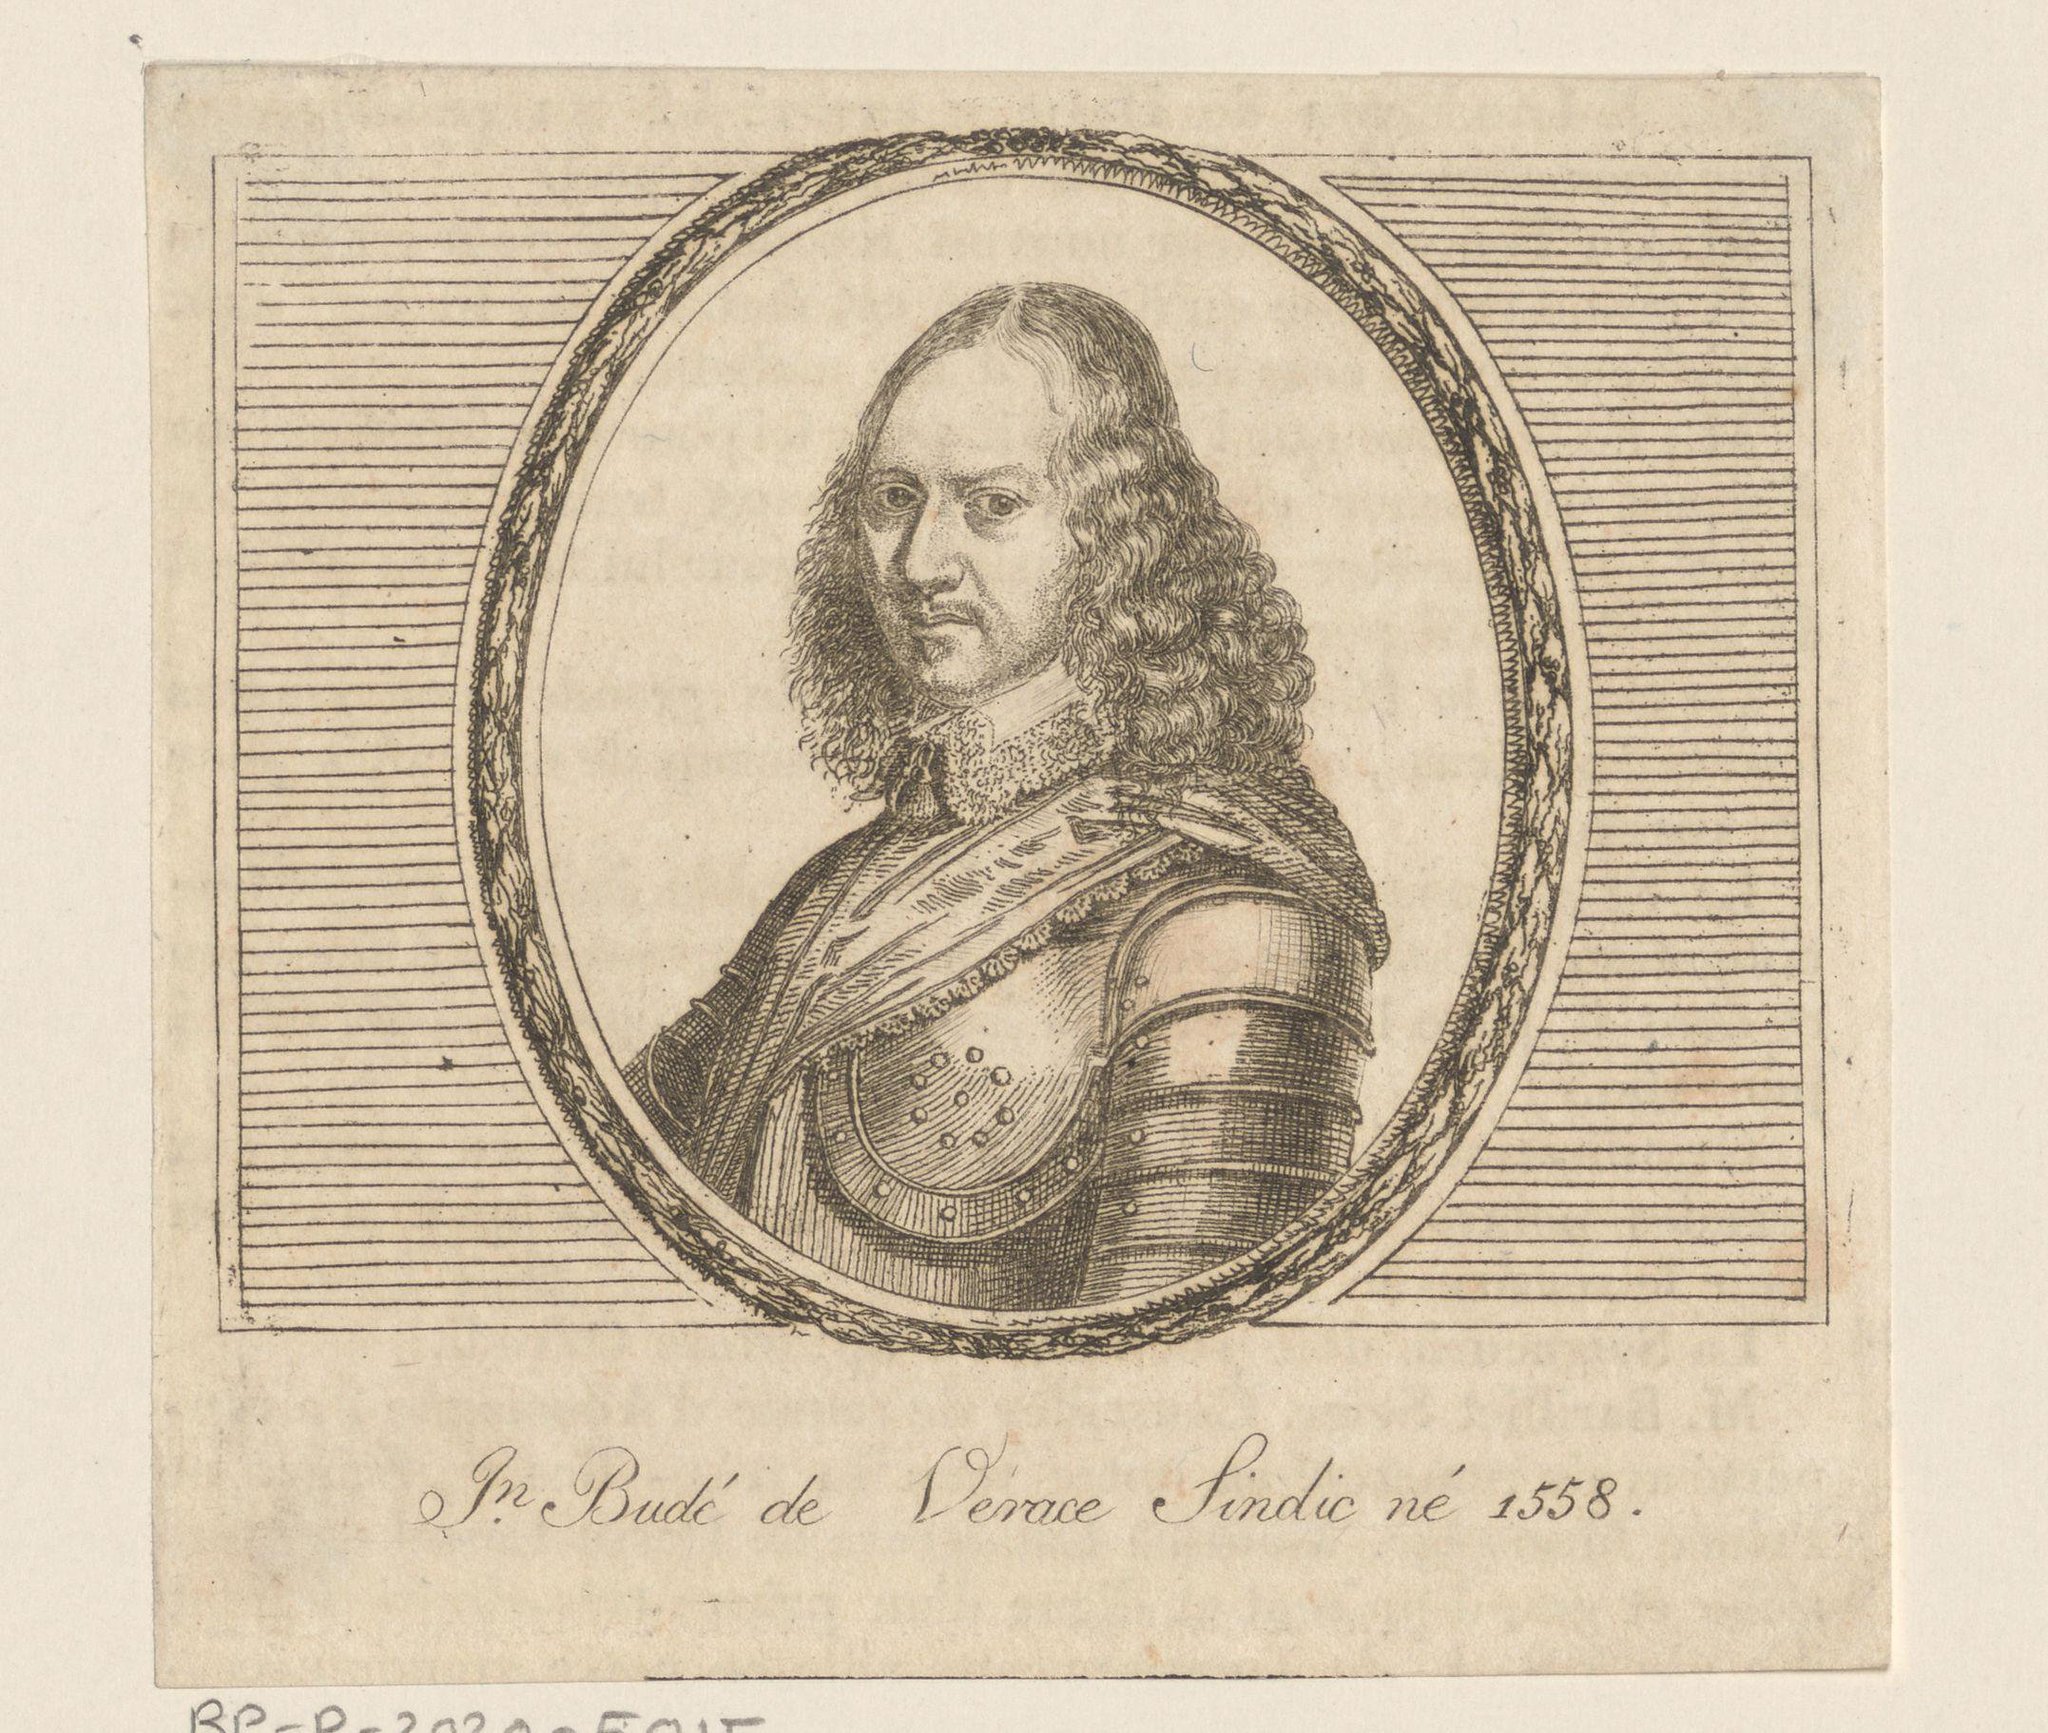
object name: print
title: Portret van Jean Budé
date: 1815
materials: paper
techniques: engraving, etching, letterpress printing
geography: geneva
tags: armour, historical persons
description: Prent uit: Fragmens biographiques et historiques, extraits des registres du conseil d'État de la République de Genève (...). Genève: Gaspard Joël Manget en Abraham Cherbuliez, 1815.